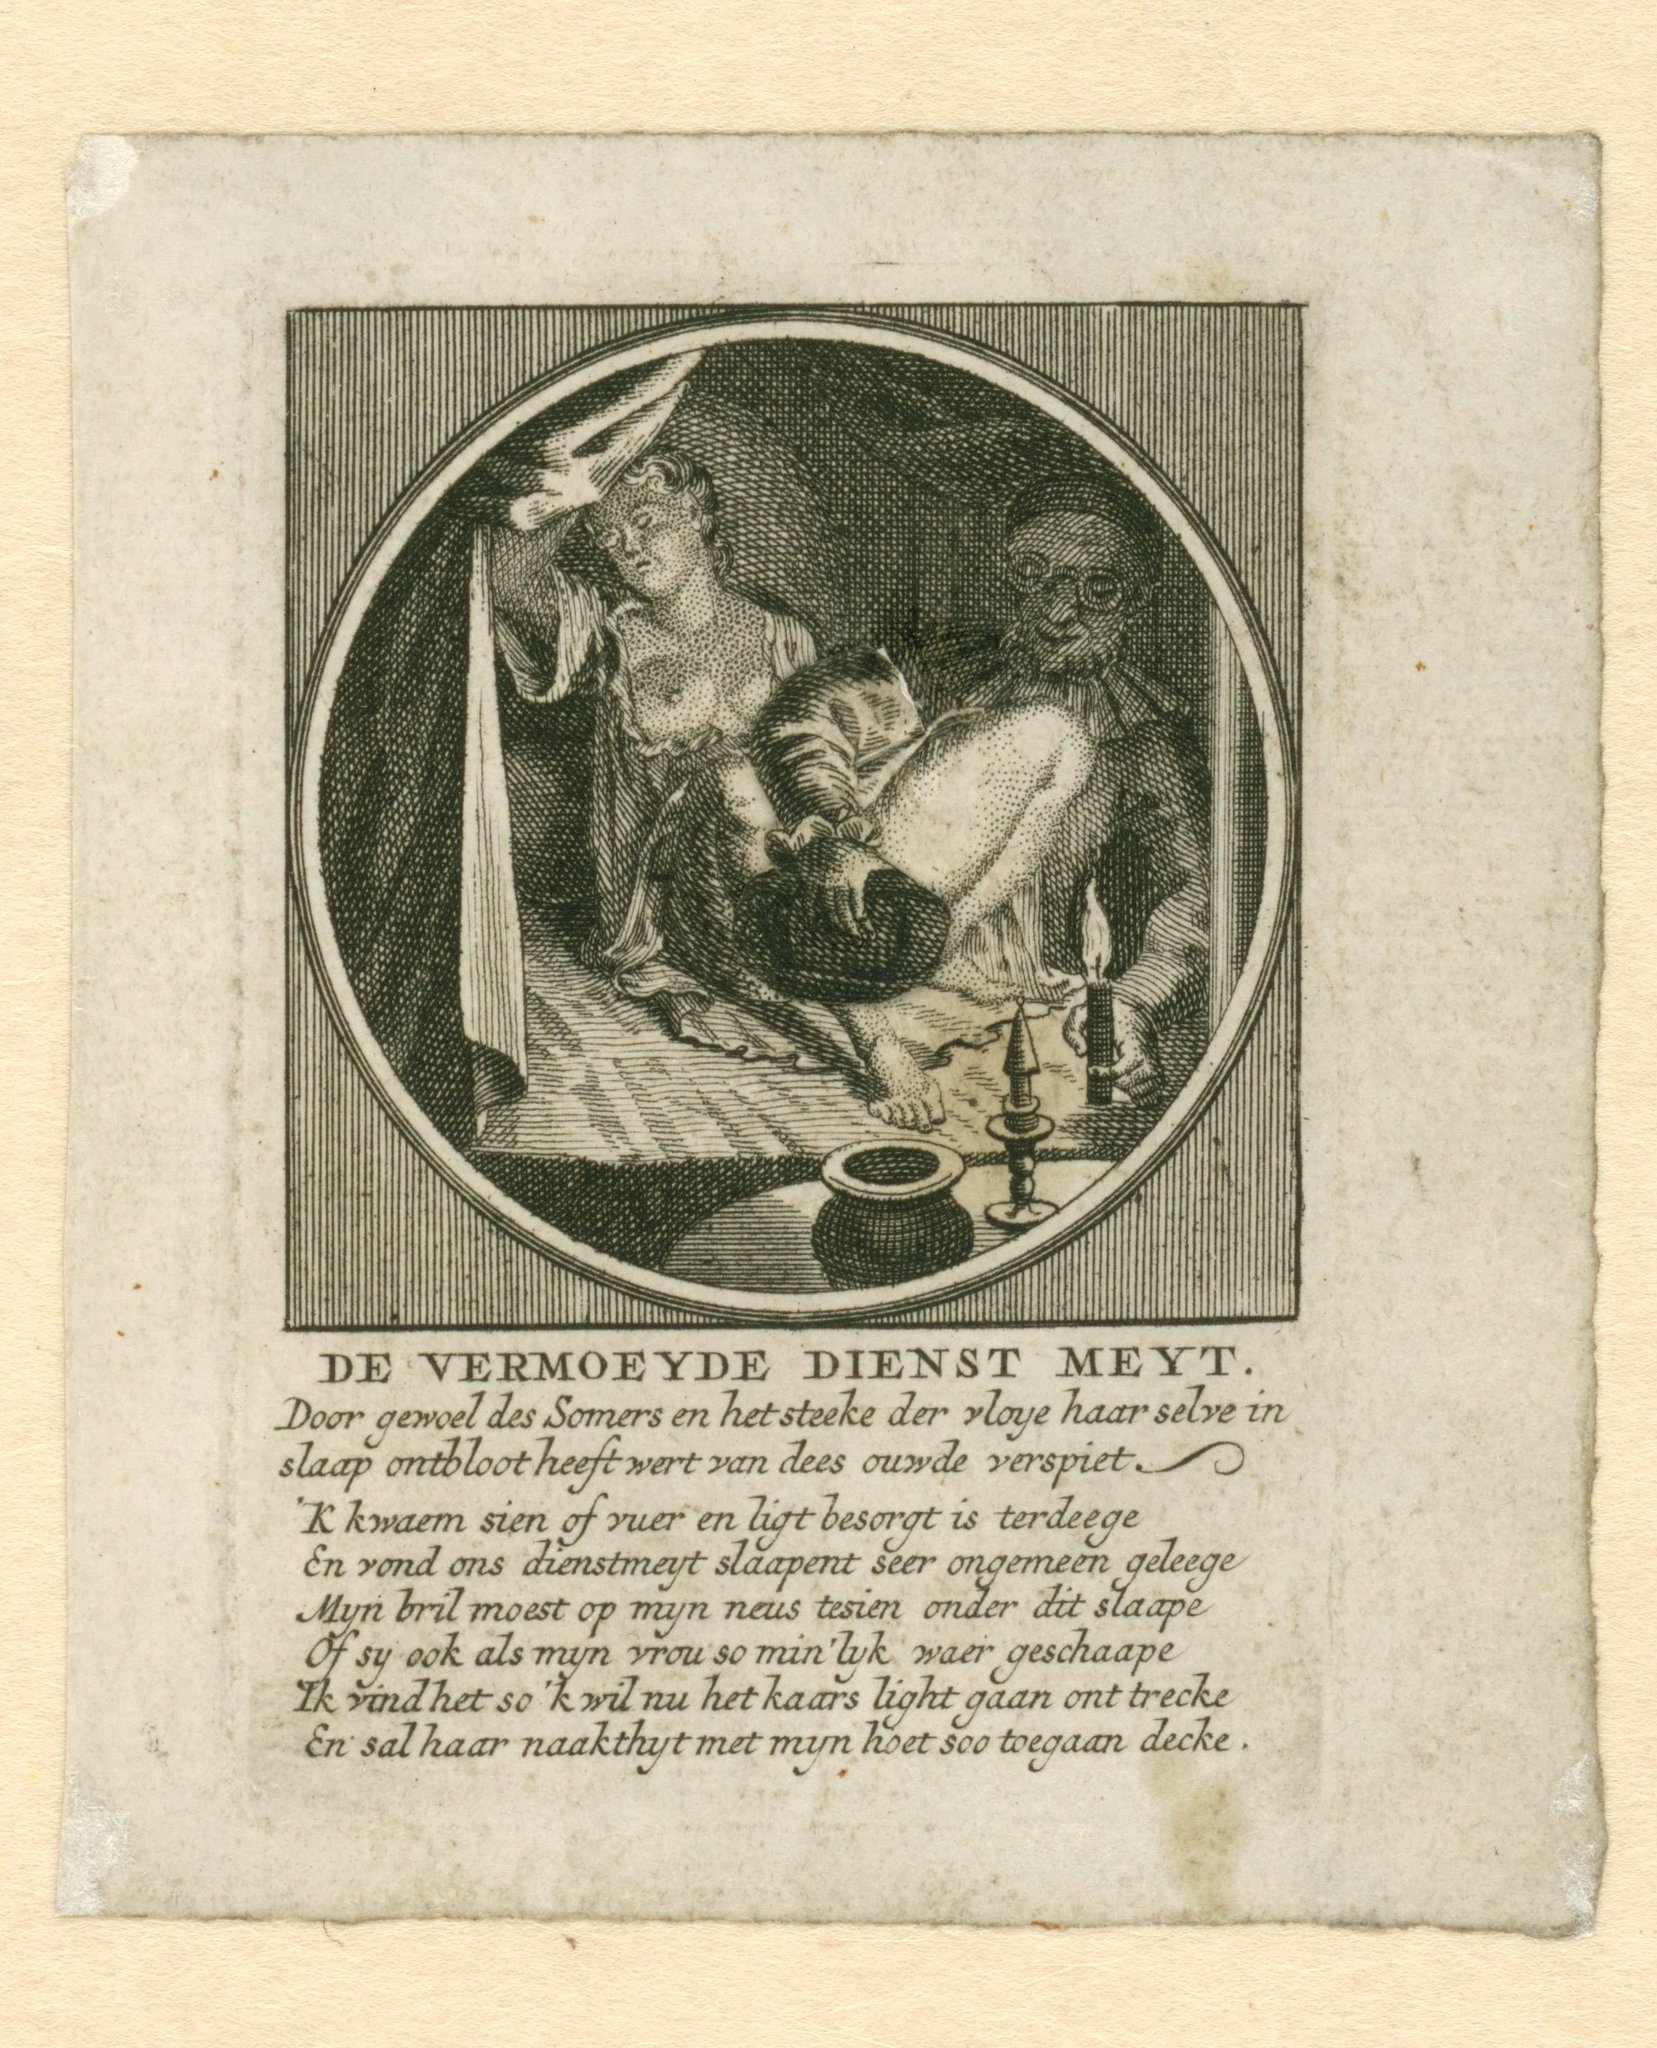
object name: print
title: De vermoeyde dienst meyt (The Tired Maidservant)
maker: Anonymous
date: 1700-1799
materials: paper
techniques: engraving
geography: netherlands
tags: sexual organs (human), peeping, voyeur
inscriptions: caption: ‘DE VERMOEYDE DIENST MEYT/Door gewoel des somers......myn hoet soo toegaan decke.’, collector's mark: Lugt 2228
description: The master of the house chances upon his practically naked maidservant in bed. His curiosity aroused, he has put on his spectacles to compare her body with that of his spouse. He covers her vagina with his hat, apparently for the sake of ‘decorum’. Erotic prints were often anonymous because engravers did not want to risk their reputation.